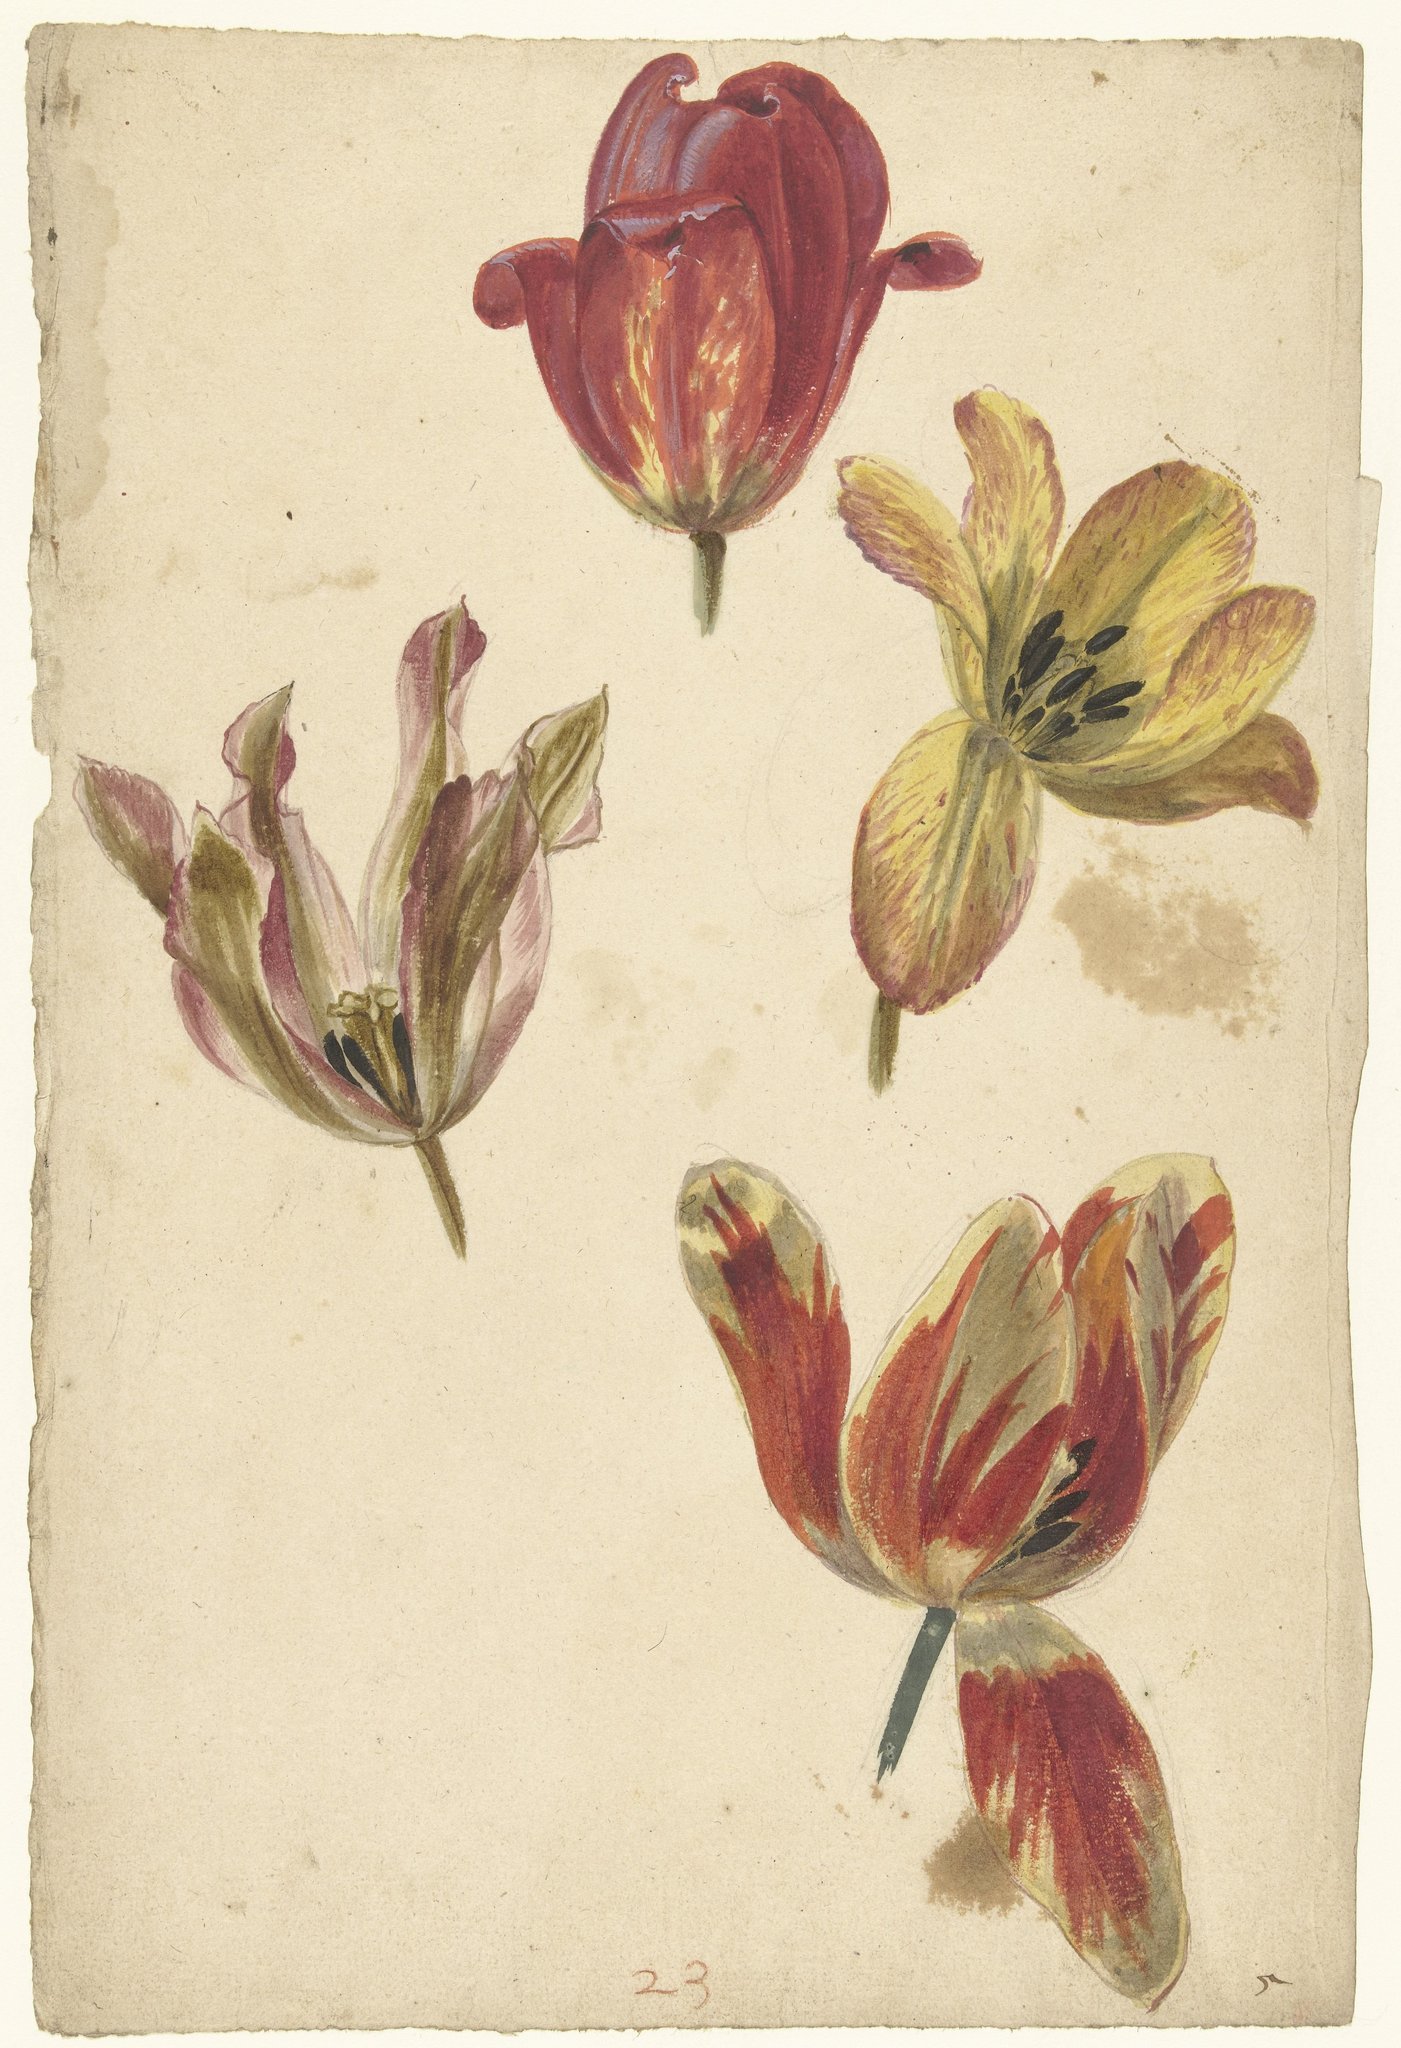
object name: drawing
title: Studies of Four Tulips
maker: elias van nijmegen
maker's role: draughtsman, painter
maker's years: 1667-1755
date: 1700-1725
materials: paper, pencil, watercolor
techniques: brush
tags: flowers: tulip